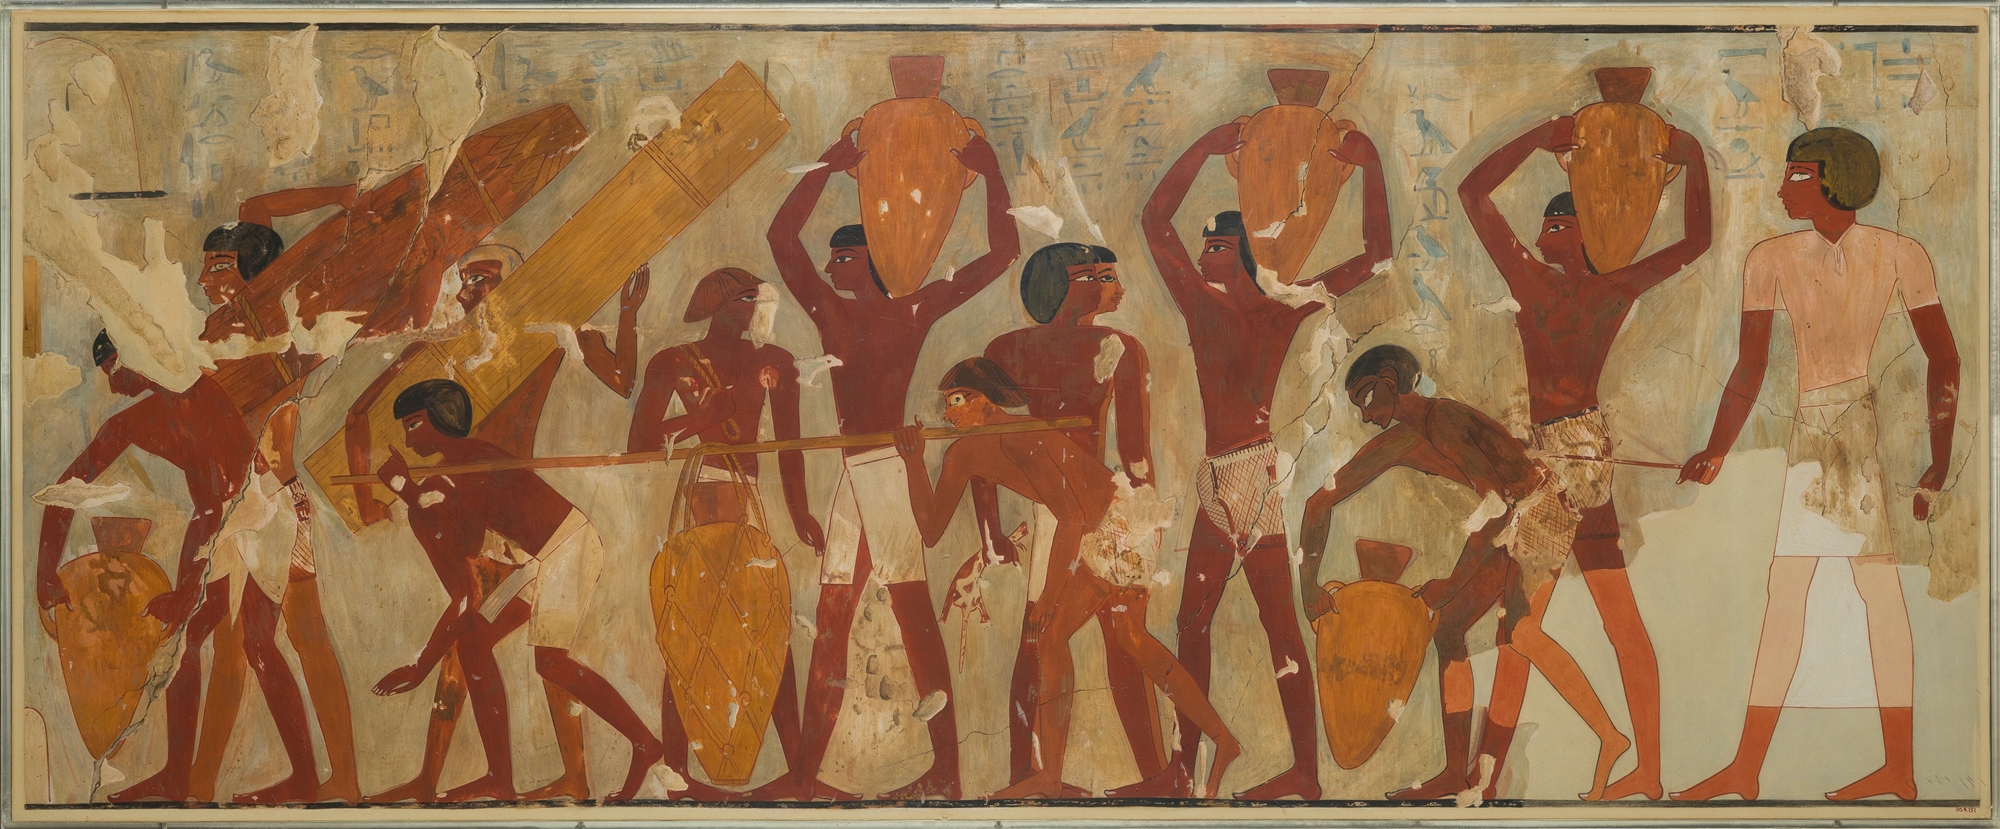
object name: facsimile, rekhmire tt 100, treasury of amun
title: Wine and Papyrus for the Treasuries of Amun, Tomb of Rekhmire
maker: charles k. wilkinson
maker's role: artist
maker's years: 1897-1986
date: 1479-1420 BCE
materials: paper, paint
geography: egypt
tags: wine,working,rekhmire-exhibition